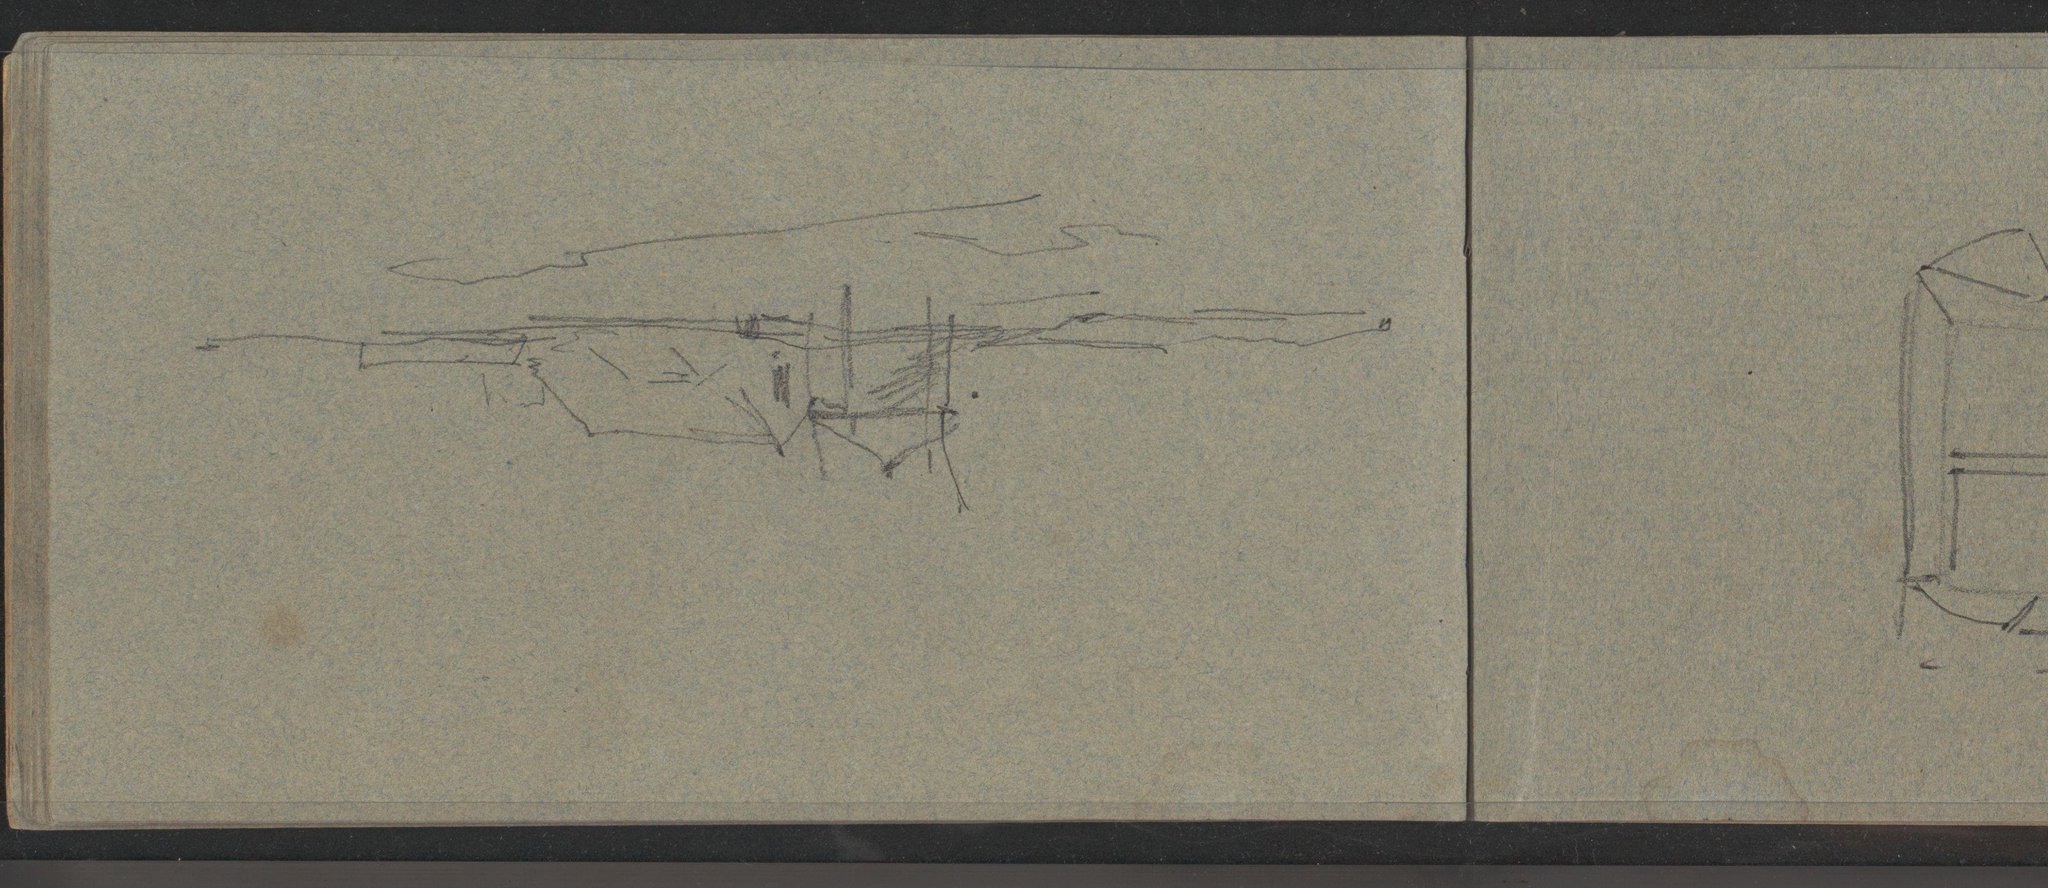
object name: sketchbook leaf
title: Boerderij in een landschap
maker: george hendrik breitner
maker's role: draughtsman, painter, print maker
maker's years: 1857-1923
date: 1883-1885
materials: paper, pencil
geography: the hague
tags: farm or solitary house in landscape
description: Blad 7 verso uit een schetsboek met 36 bladen.